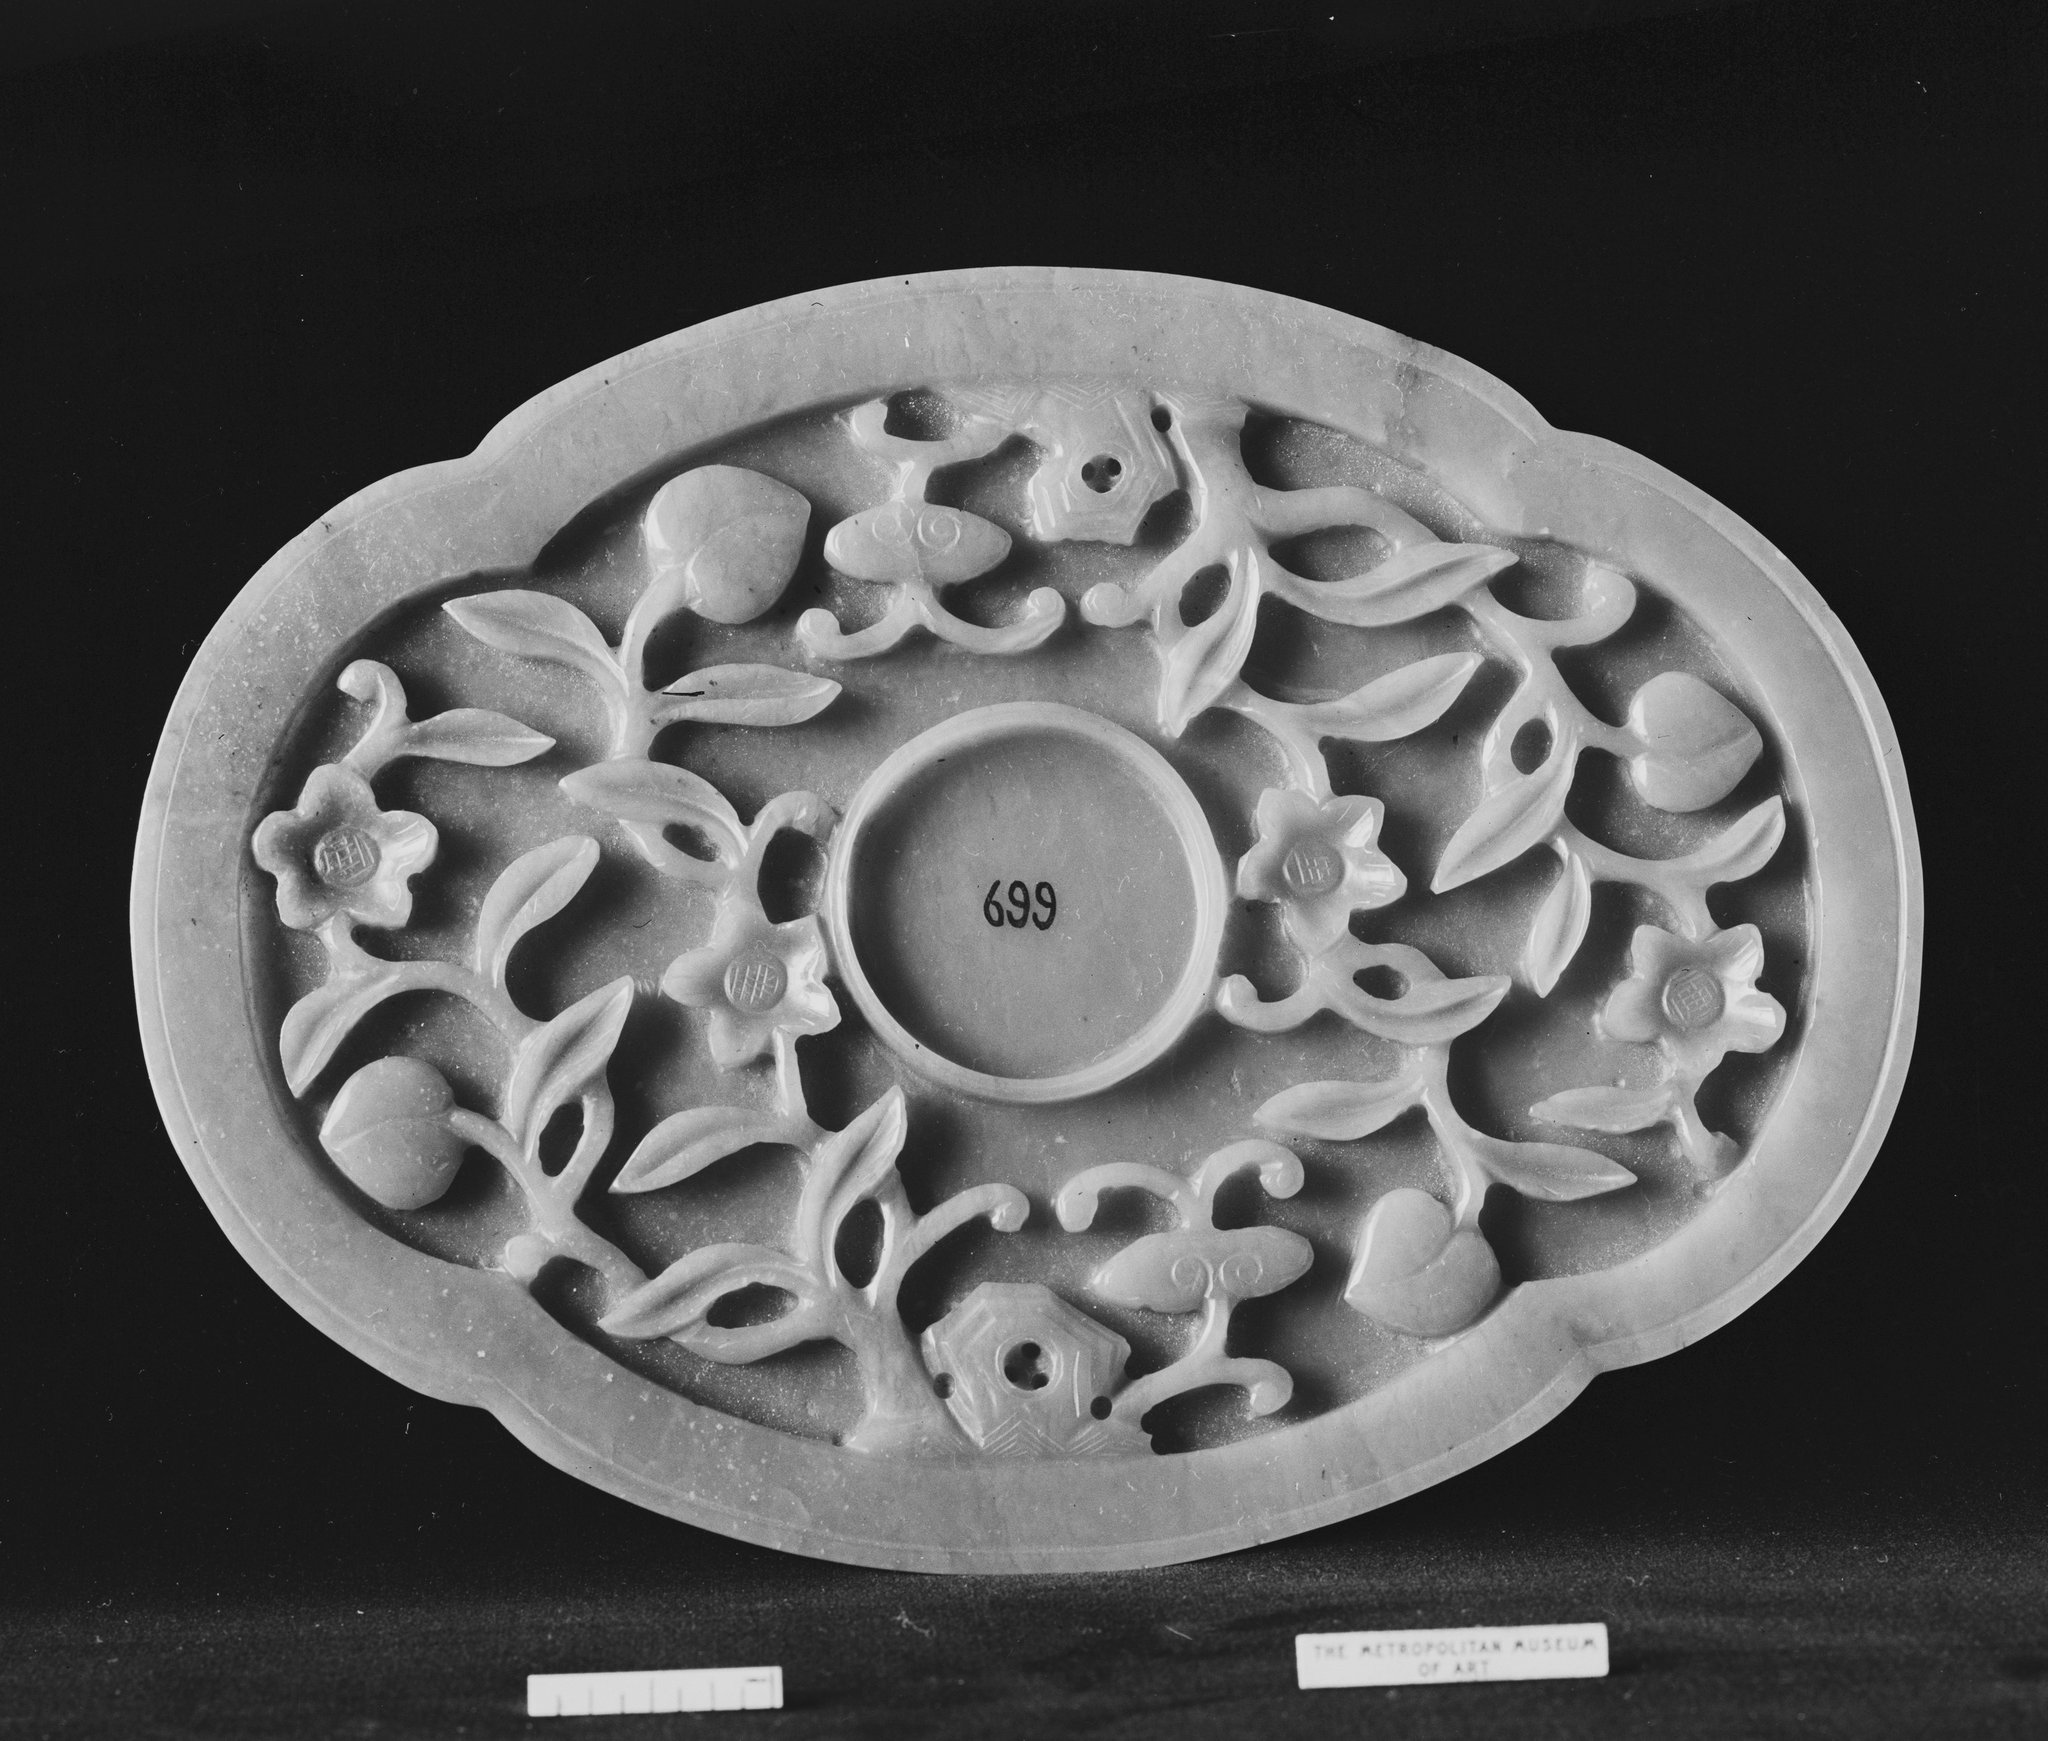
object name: tray of wine cup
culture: chinese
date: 1736-1795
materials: jade